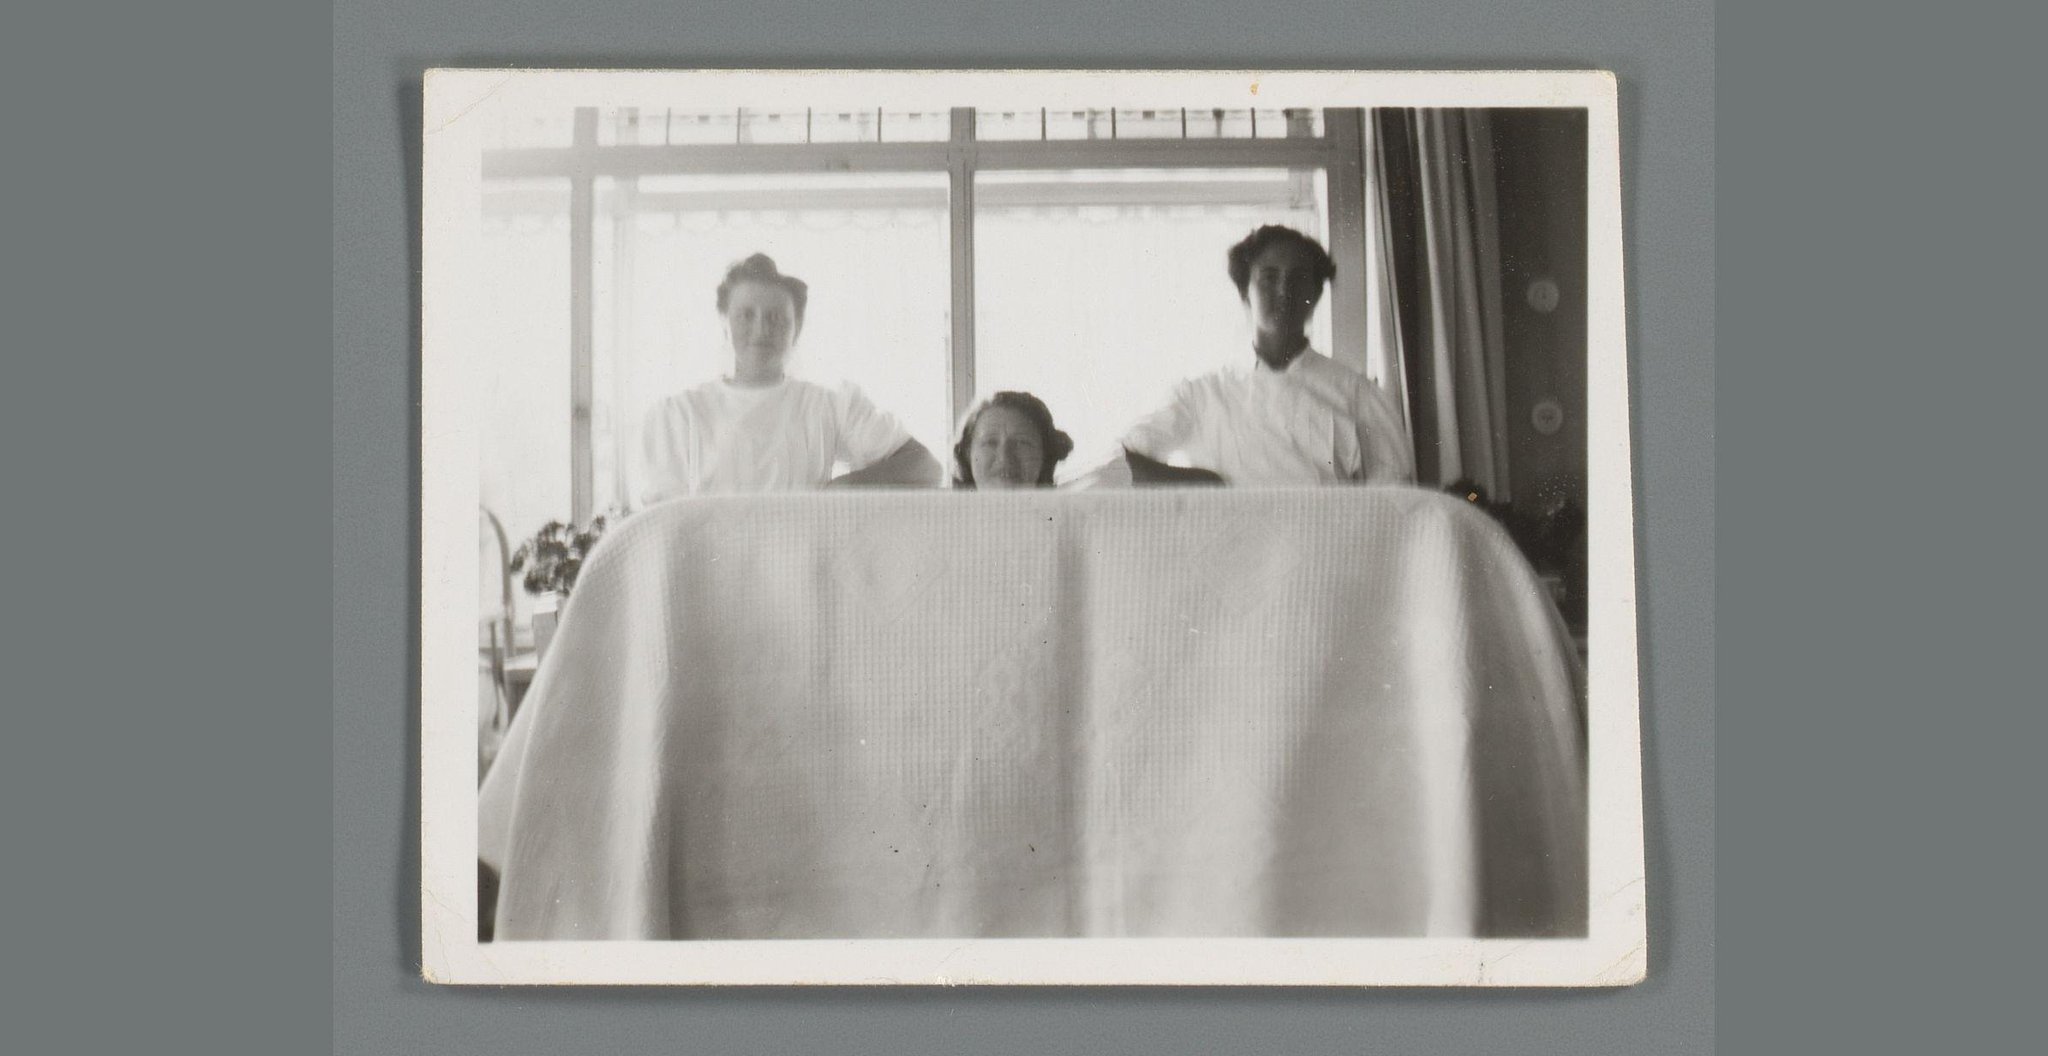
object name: photograph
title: Groepsportret van drie onbekende vrouwen bij een bed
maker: Anonymous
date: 1940-1960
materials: paper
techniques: gelatin silver print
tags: bed, anonymous historical persons portrayed in a group, in a group-portrait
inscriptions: number: ‘21’